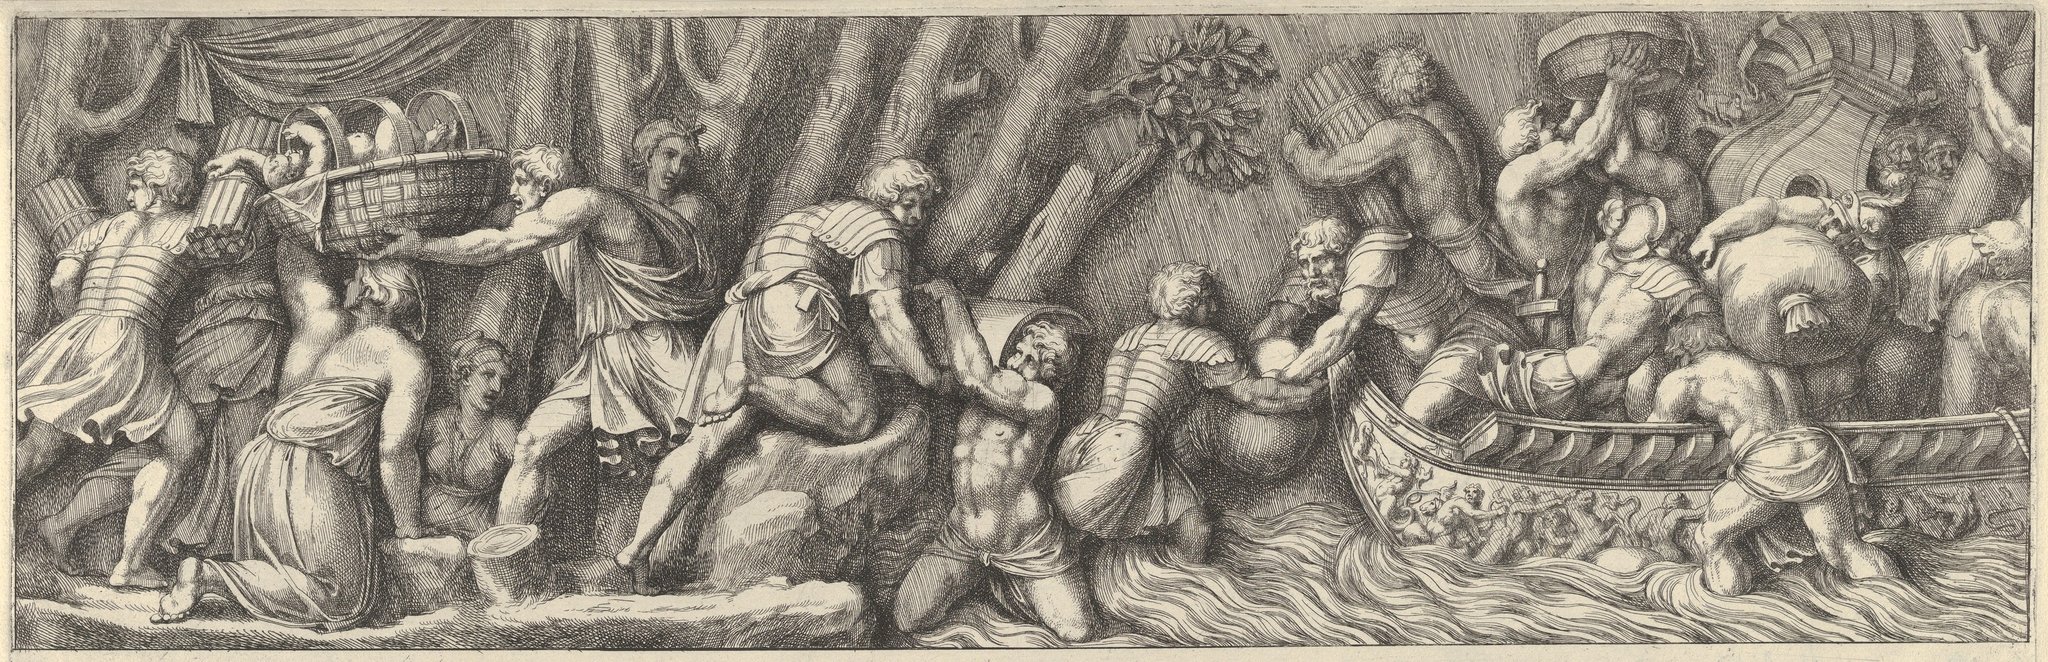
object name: print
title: Plate 5: figures unloading goods from a boat at the right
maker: pietro santi bartoli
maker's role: artist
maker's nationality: italian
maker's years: 1615-1700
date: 1660-1690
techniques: etching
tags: men,women,working,boats